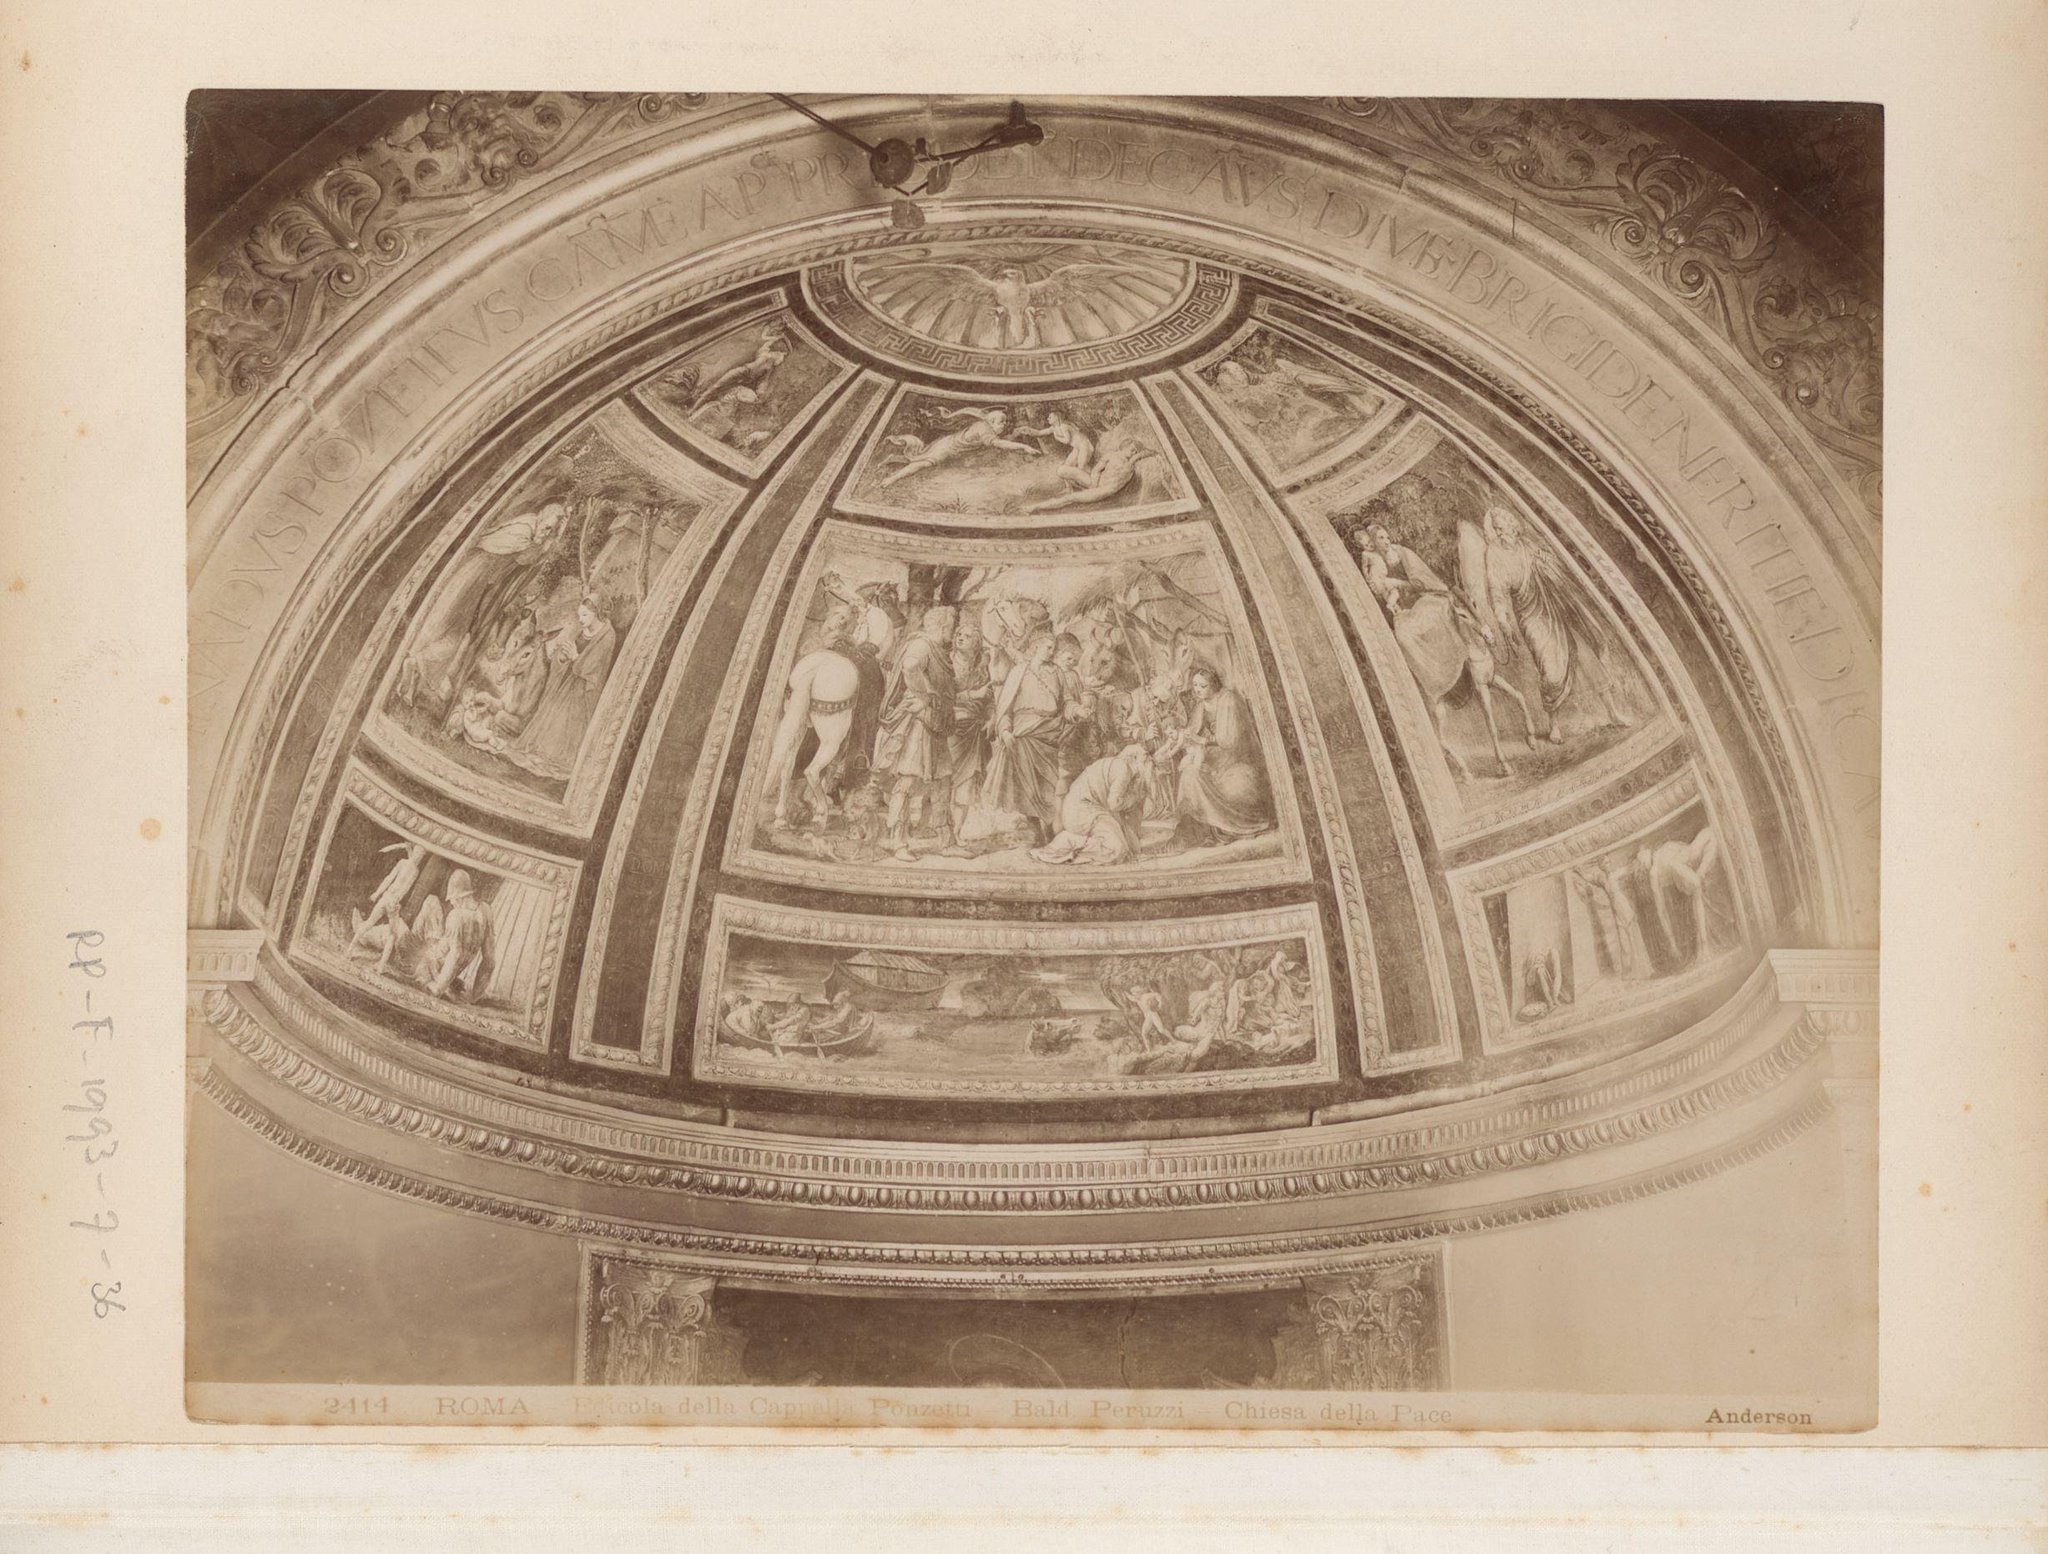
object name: photograph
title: 2414 - Roma - Edicola della Capella Ponzetti - Bald. Peruzzi - Chiesa della Pace.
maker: james anderson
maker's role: fotograaf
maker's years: 1813-1877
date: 1857-1875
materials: paper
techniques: albumen print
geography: santa maria della pace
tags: interior of church, picture, painting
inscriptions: inscription: ‘2414 - ROMA - Edicola della Capella Ponzetti - Bald. Peruzzi - Chiesa della Pace. Anderson’